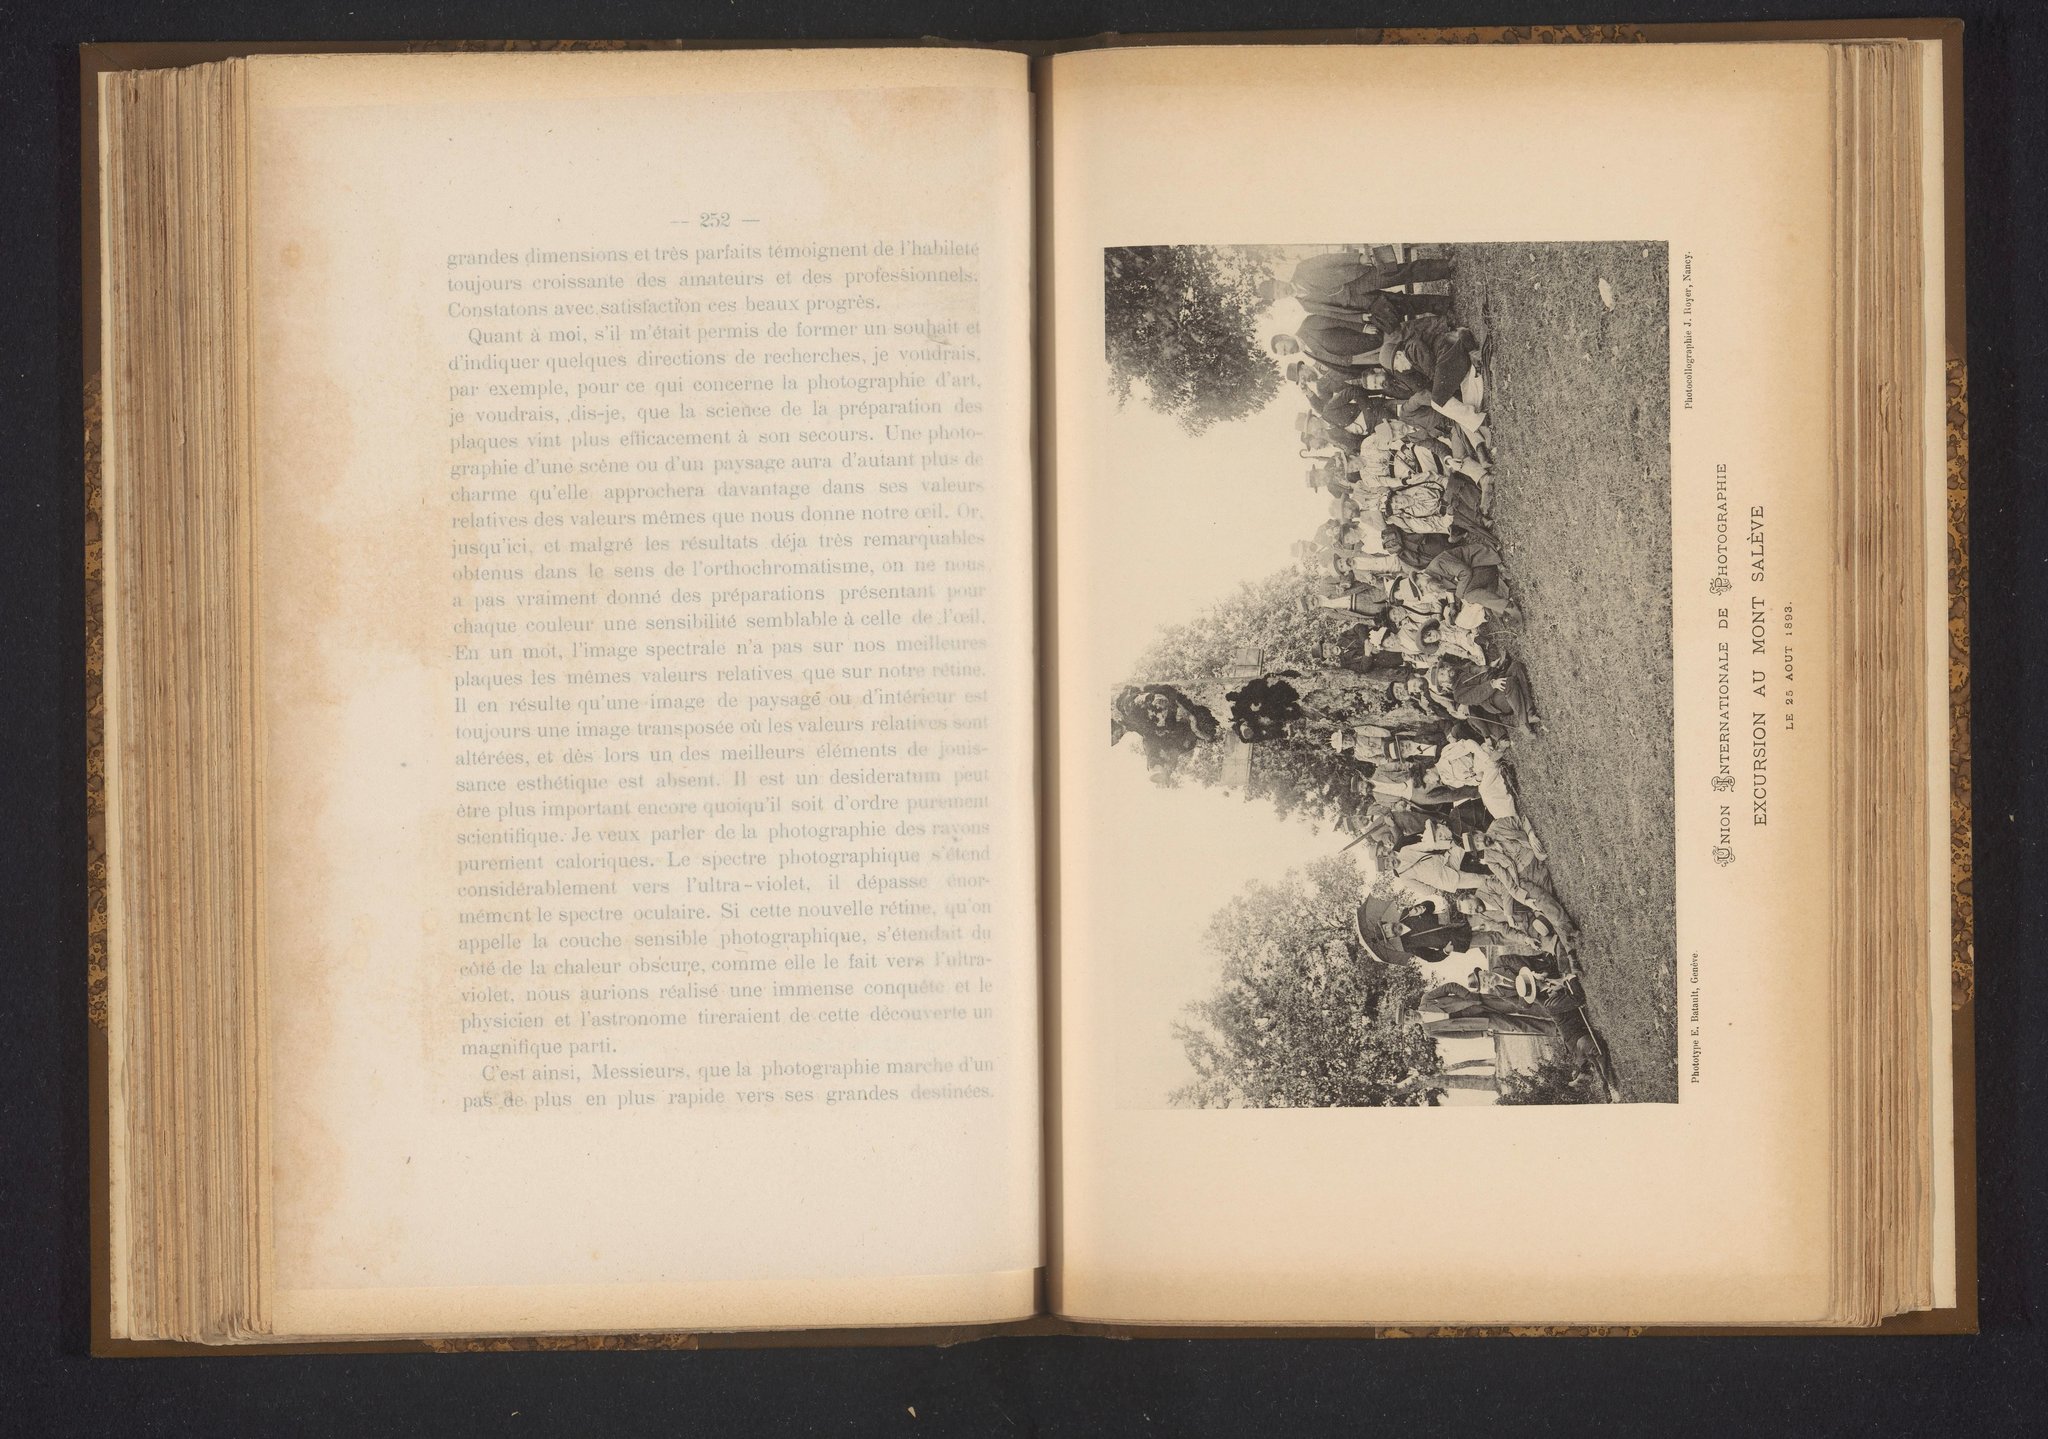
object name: photomechanical print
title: Union Internationale de Photographie - Excursion au Mont Salève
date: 1893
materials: paper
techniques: photograph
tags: anonymous historical persons portrayed in a group, in a group-portrait